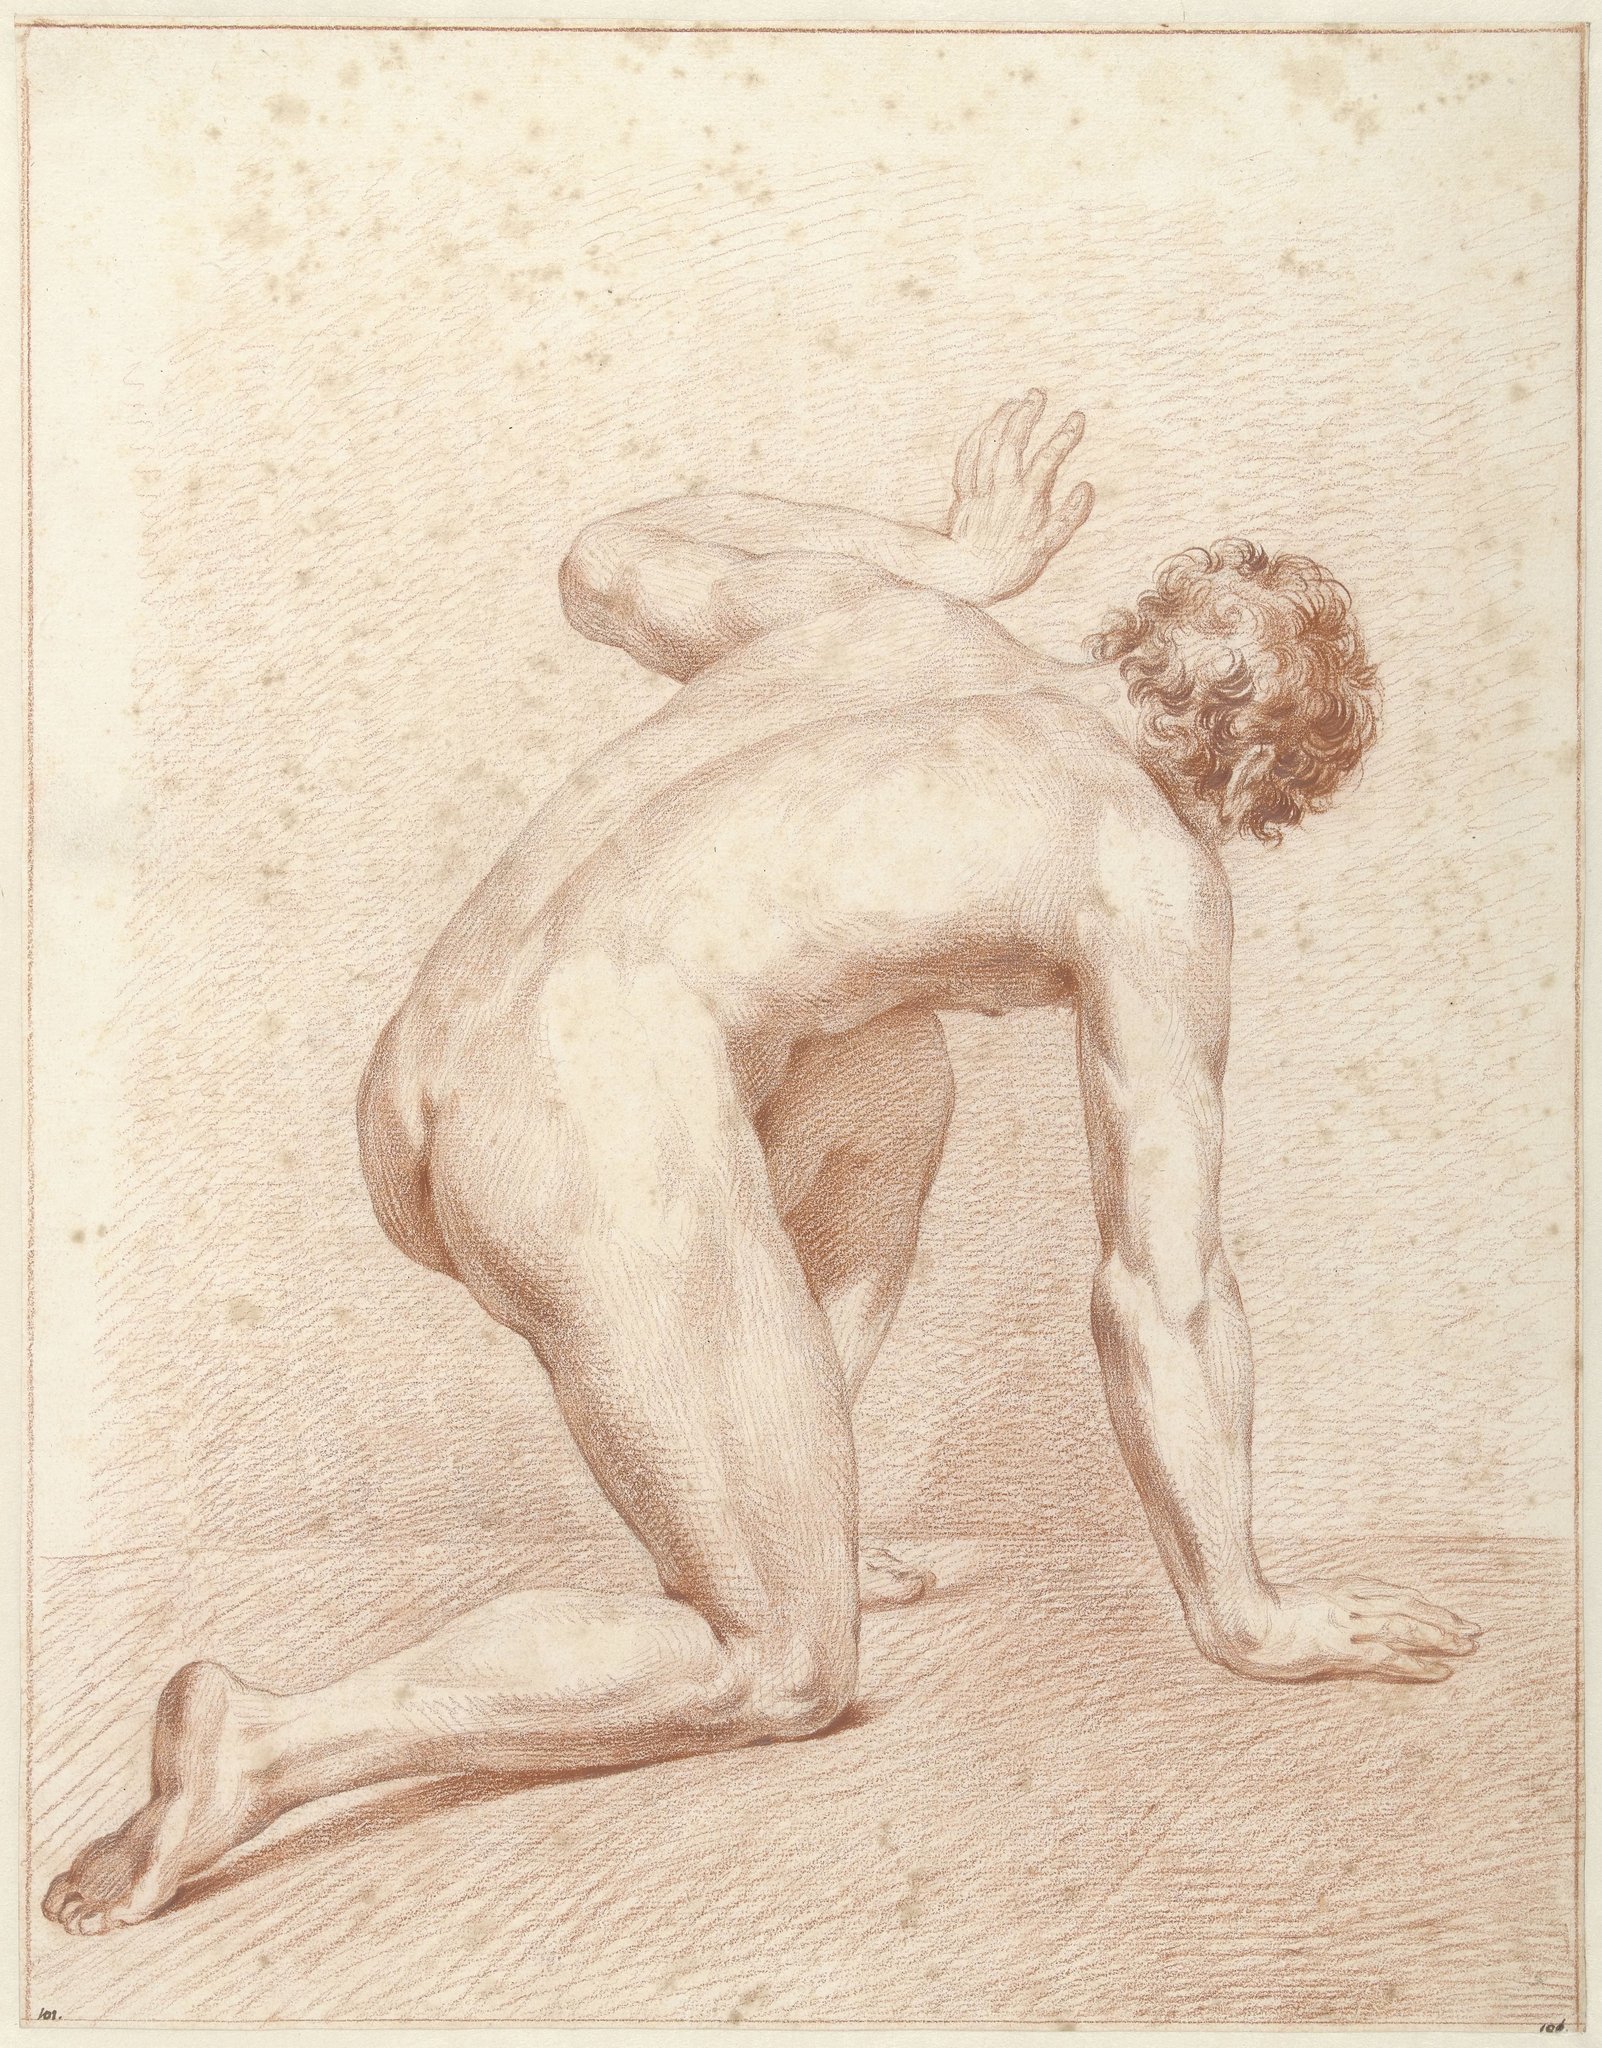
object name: drawing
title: Mannelijk naakt, knielend, op de rug gezien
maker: jacob willemz. de vos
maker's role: draughtsman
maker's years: 1774-1844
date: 1795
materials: chalk, paper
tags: the (nude) human figure; 'corpo humano' (ripa)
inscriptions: inscription: ‘Jacob de Vos willemsz A 1795’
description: Mannelijk naakt, knielend, op de rug gezien. No. 101.